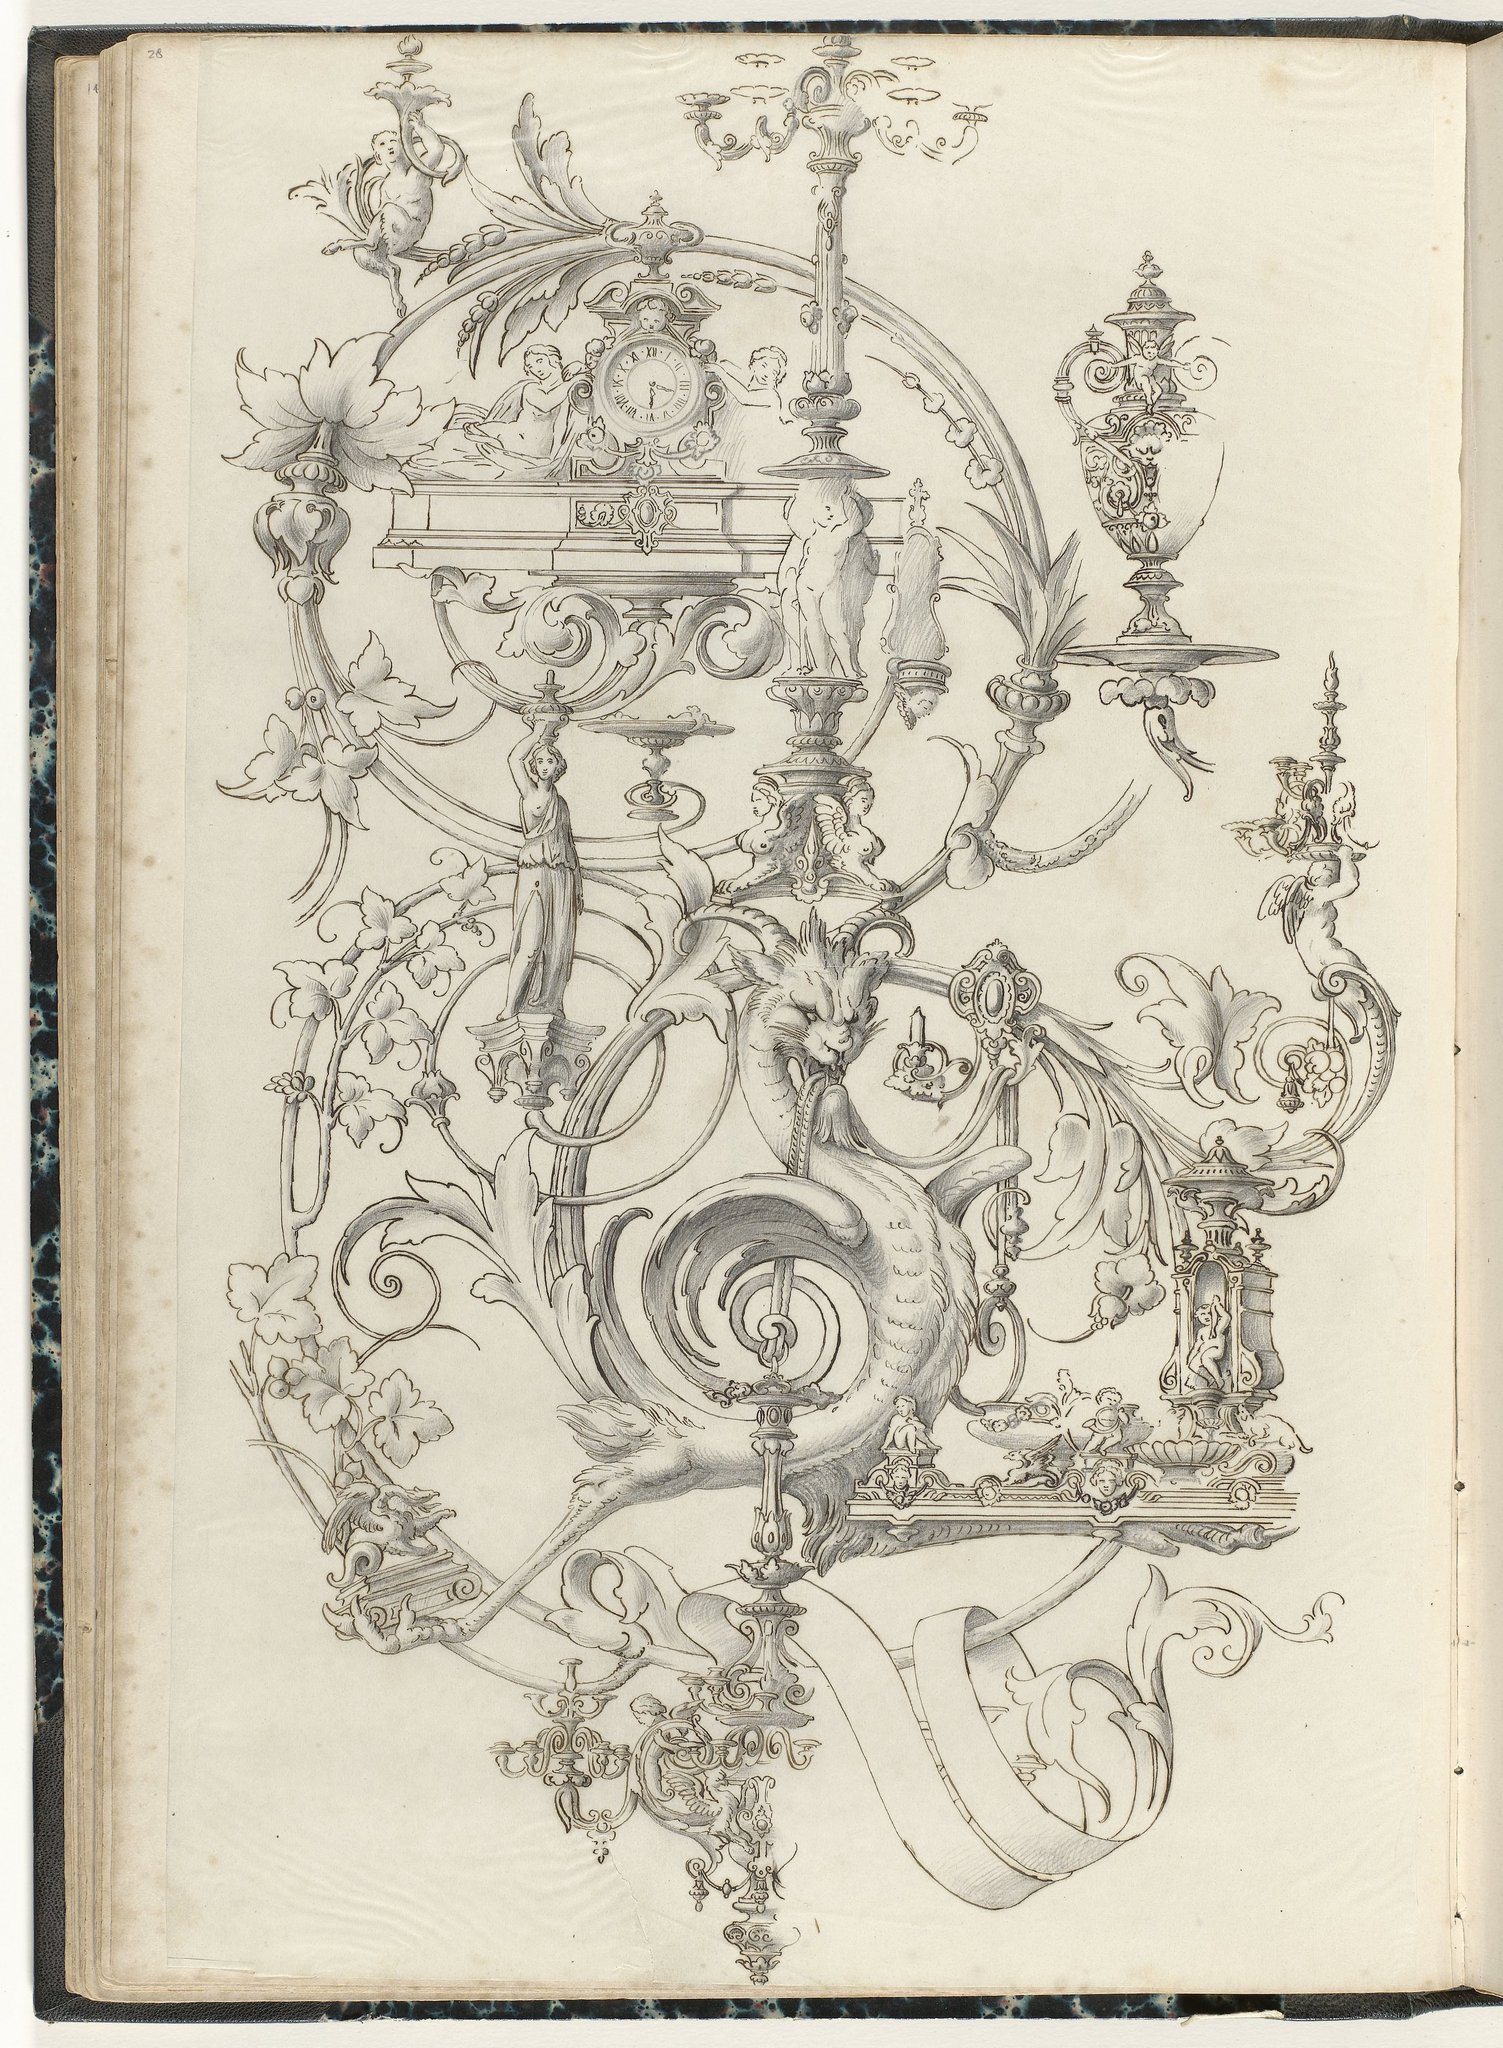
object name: drawing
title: Bladrank met objecten en figuren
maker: Anonymous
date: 1866-1900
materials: ink, pencil, paper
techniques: drawing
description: De bladrank loopt uit in drie voluten, waarvan de onderste de vorm van een fantasiedier met hoorns heeft.